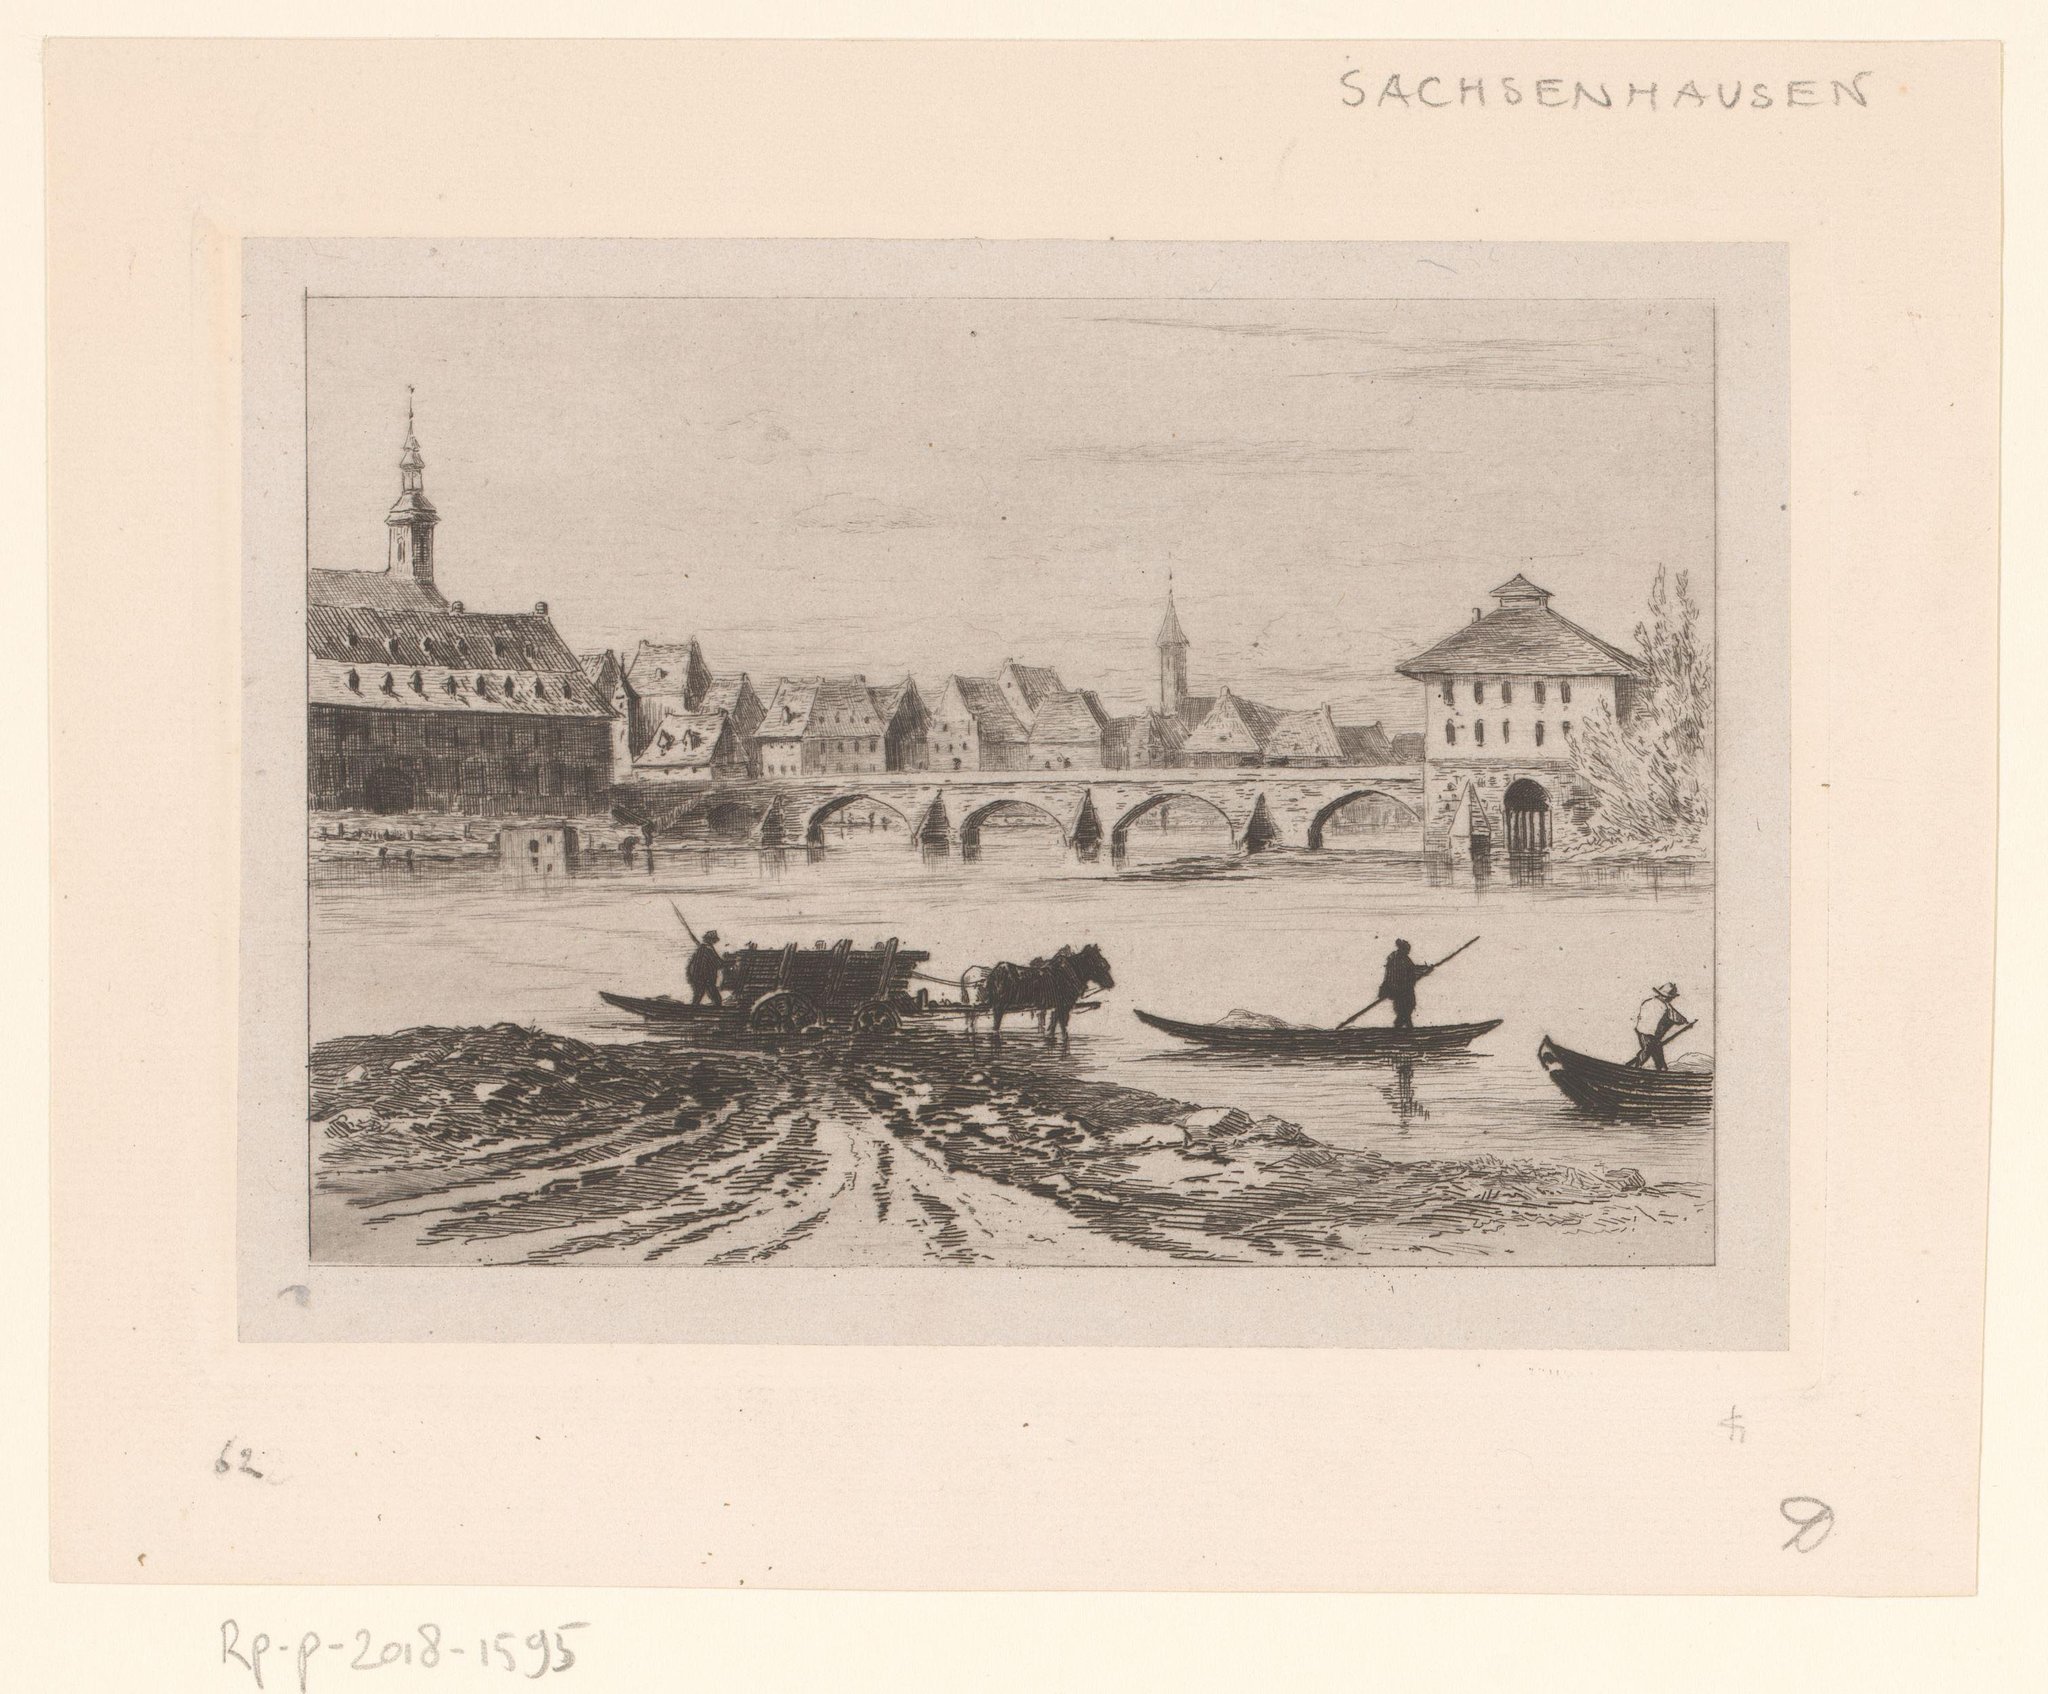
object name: print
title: Gezicht op Sachsenhausen, bij Frankfurt am Main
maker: Anonymous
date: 1800-1899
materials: paper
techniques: etching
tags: prospect of city, town panorama, silhouette of city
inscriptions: collector's mark: Lugt 2228